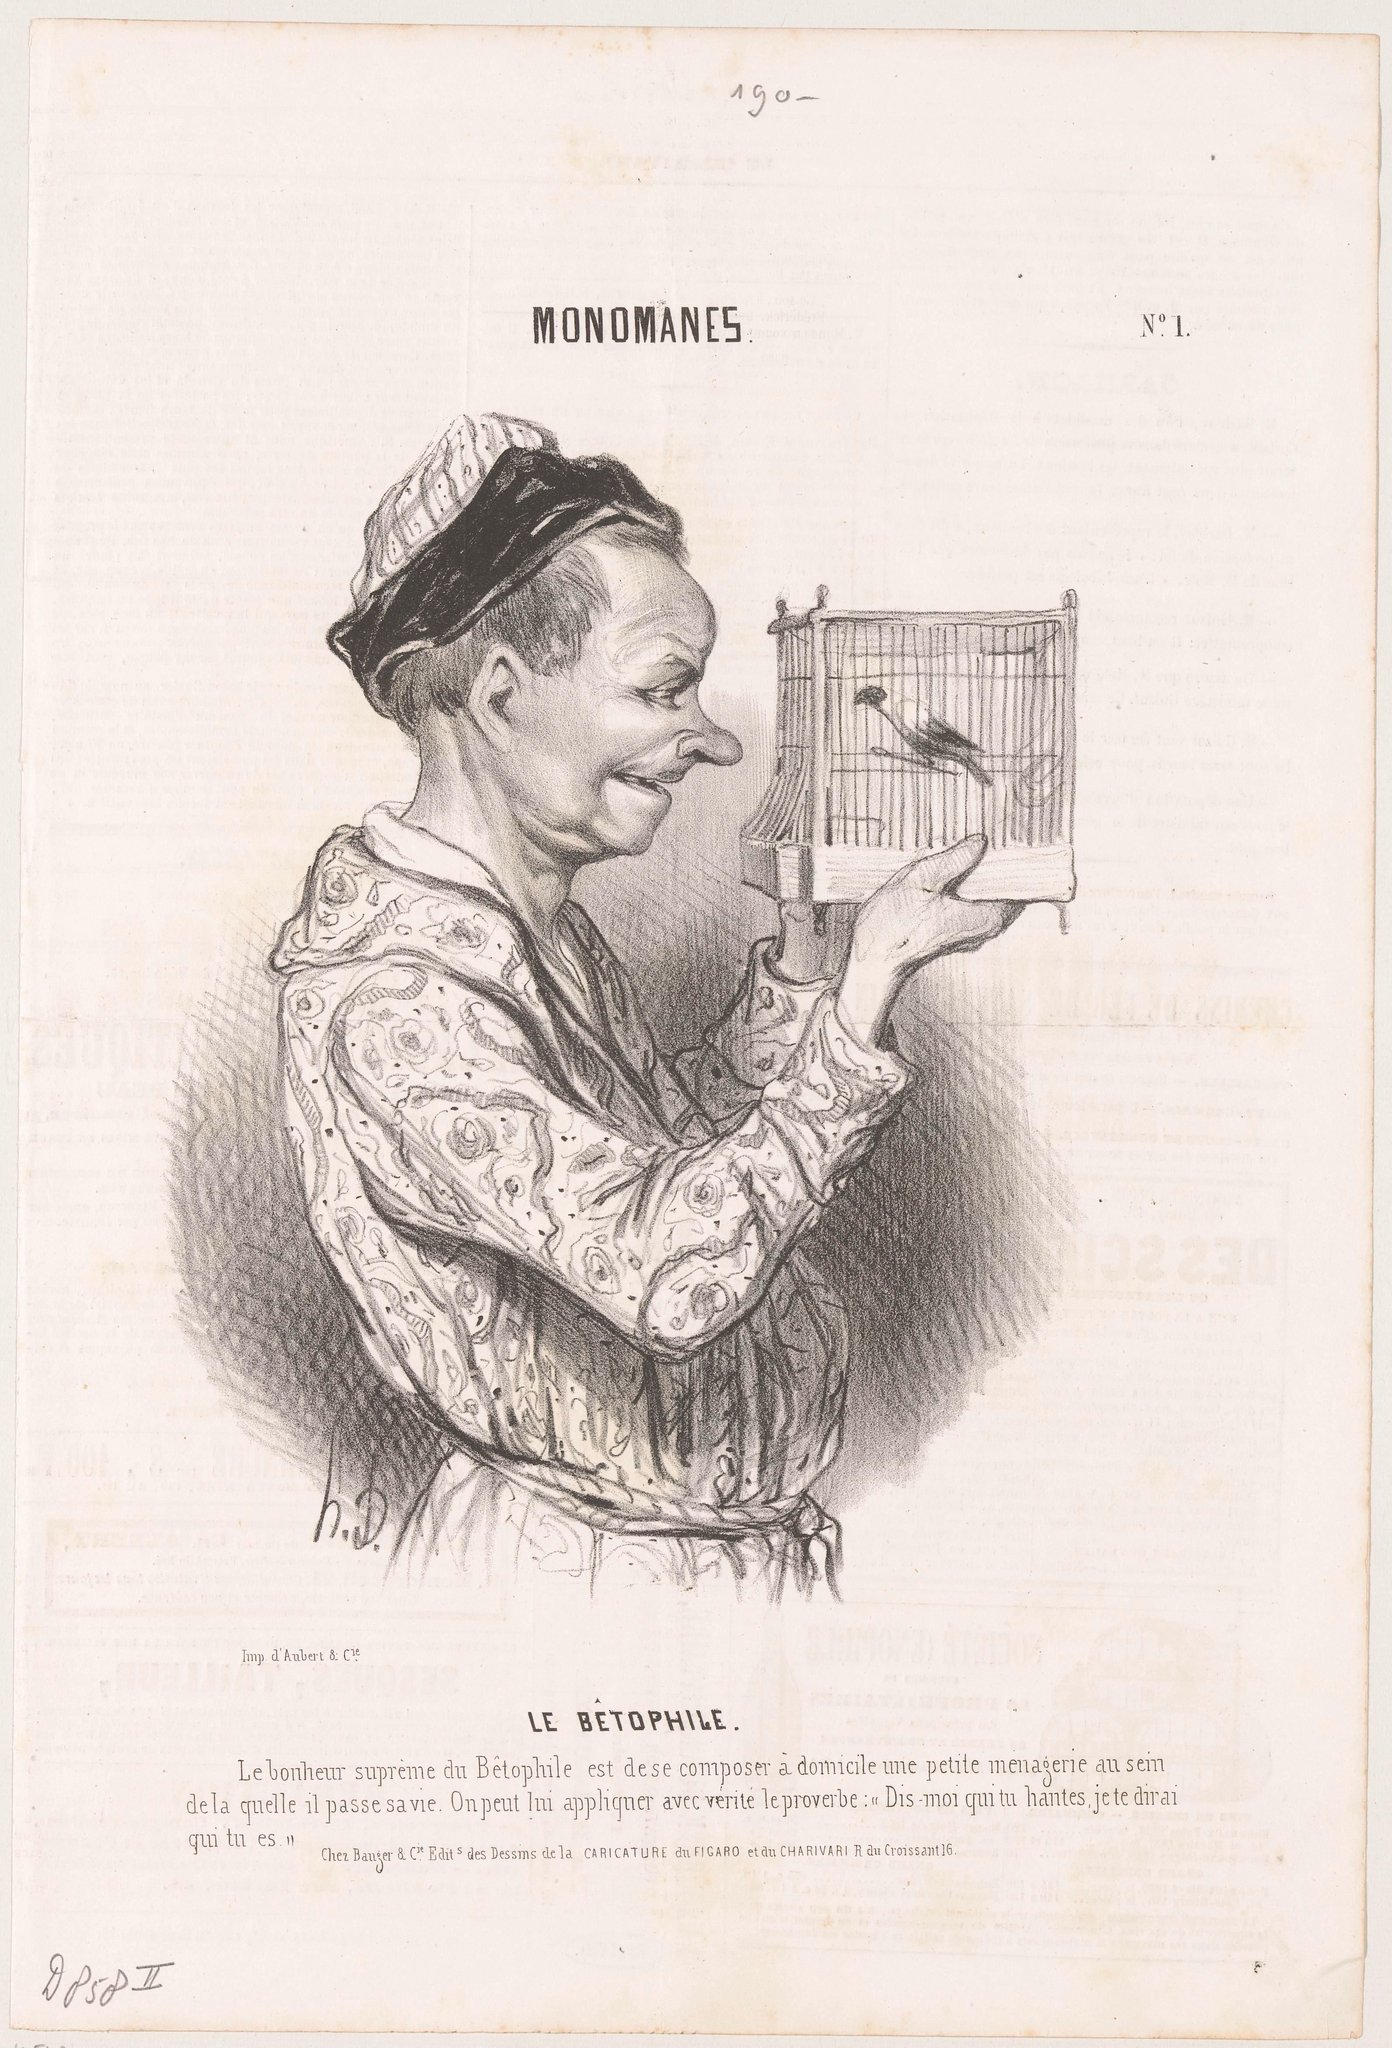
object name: cartoon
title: Maniakken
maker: honoré daumier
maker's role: draughtsman, painter, print maker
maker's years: 1808-1879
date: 1841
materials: paper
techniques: letterpress printing, lithograph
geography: paris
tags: caricatures (human types), bird in a cage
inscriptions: collector's mark: Lugt 2228a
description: Prent mogelijk uit: Le Charivari, 5 november 1841.